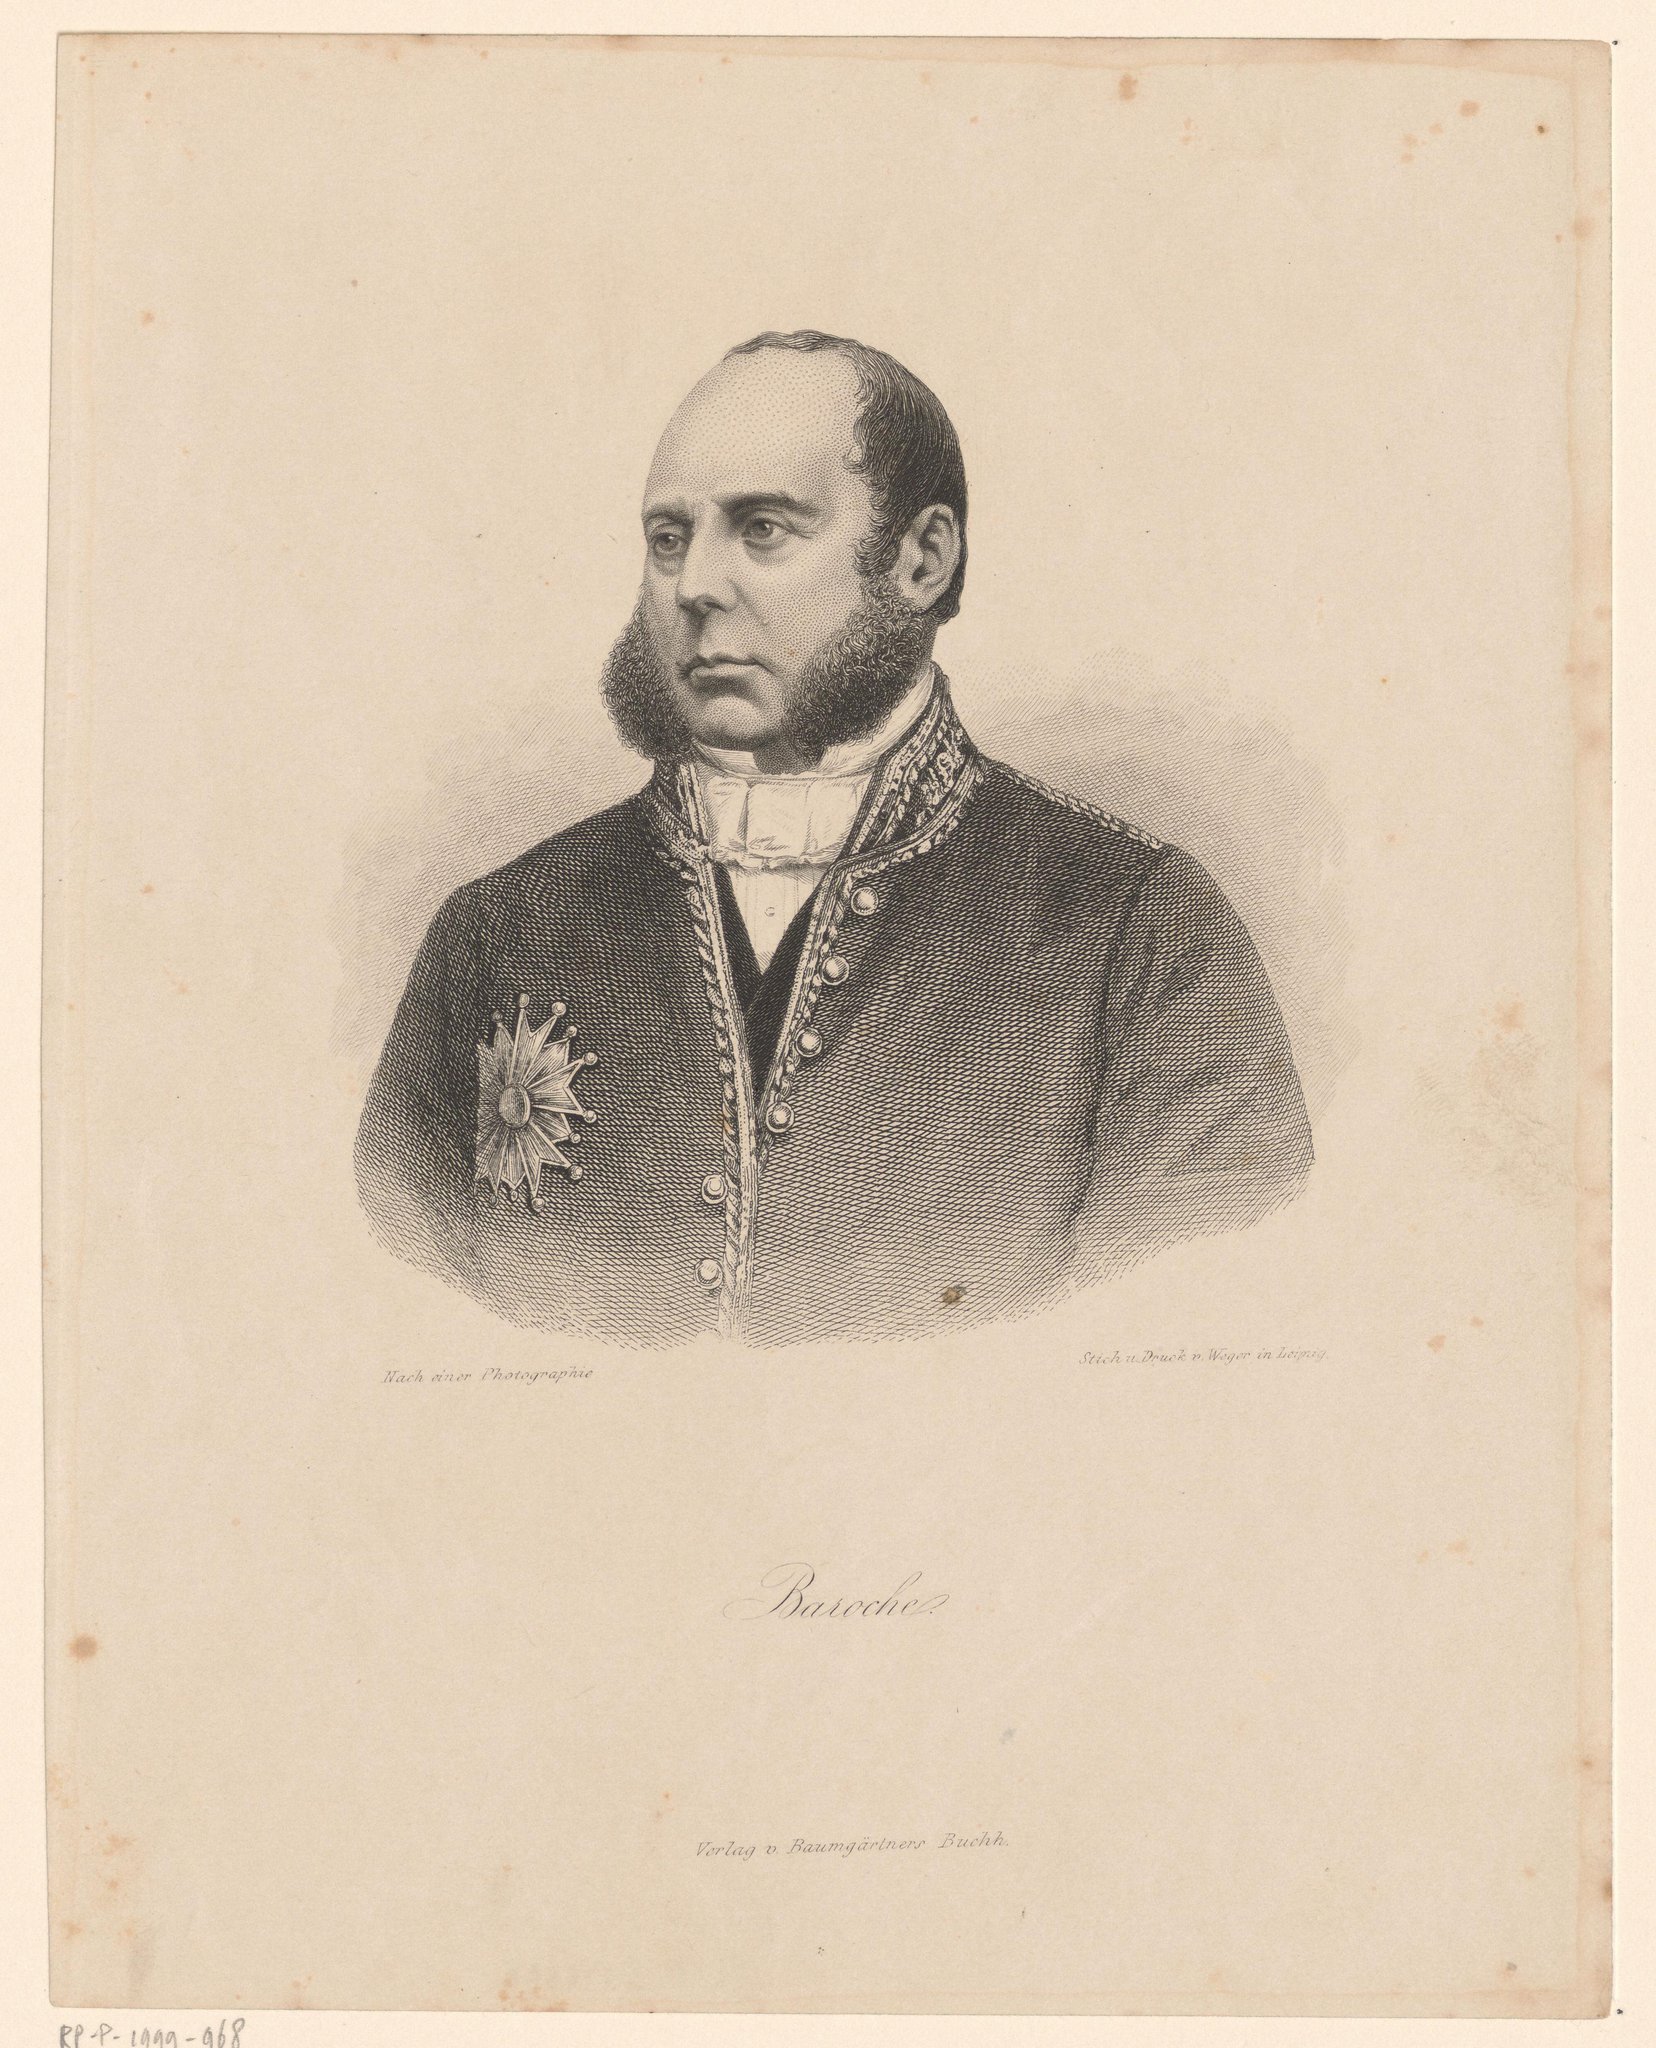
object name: print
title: Portret van Pierre-Jules Baroche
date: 1840-1892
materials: paper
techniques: engraving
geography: leipzig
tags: politician, historical persons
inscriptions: collector's mark: Lugt 2760, collector's mark: Lugt 2228, collector's mark: ‘Franz Radest[...]’